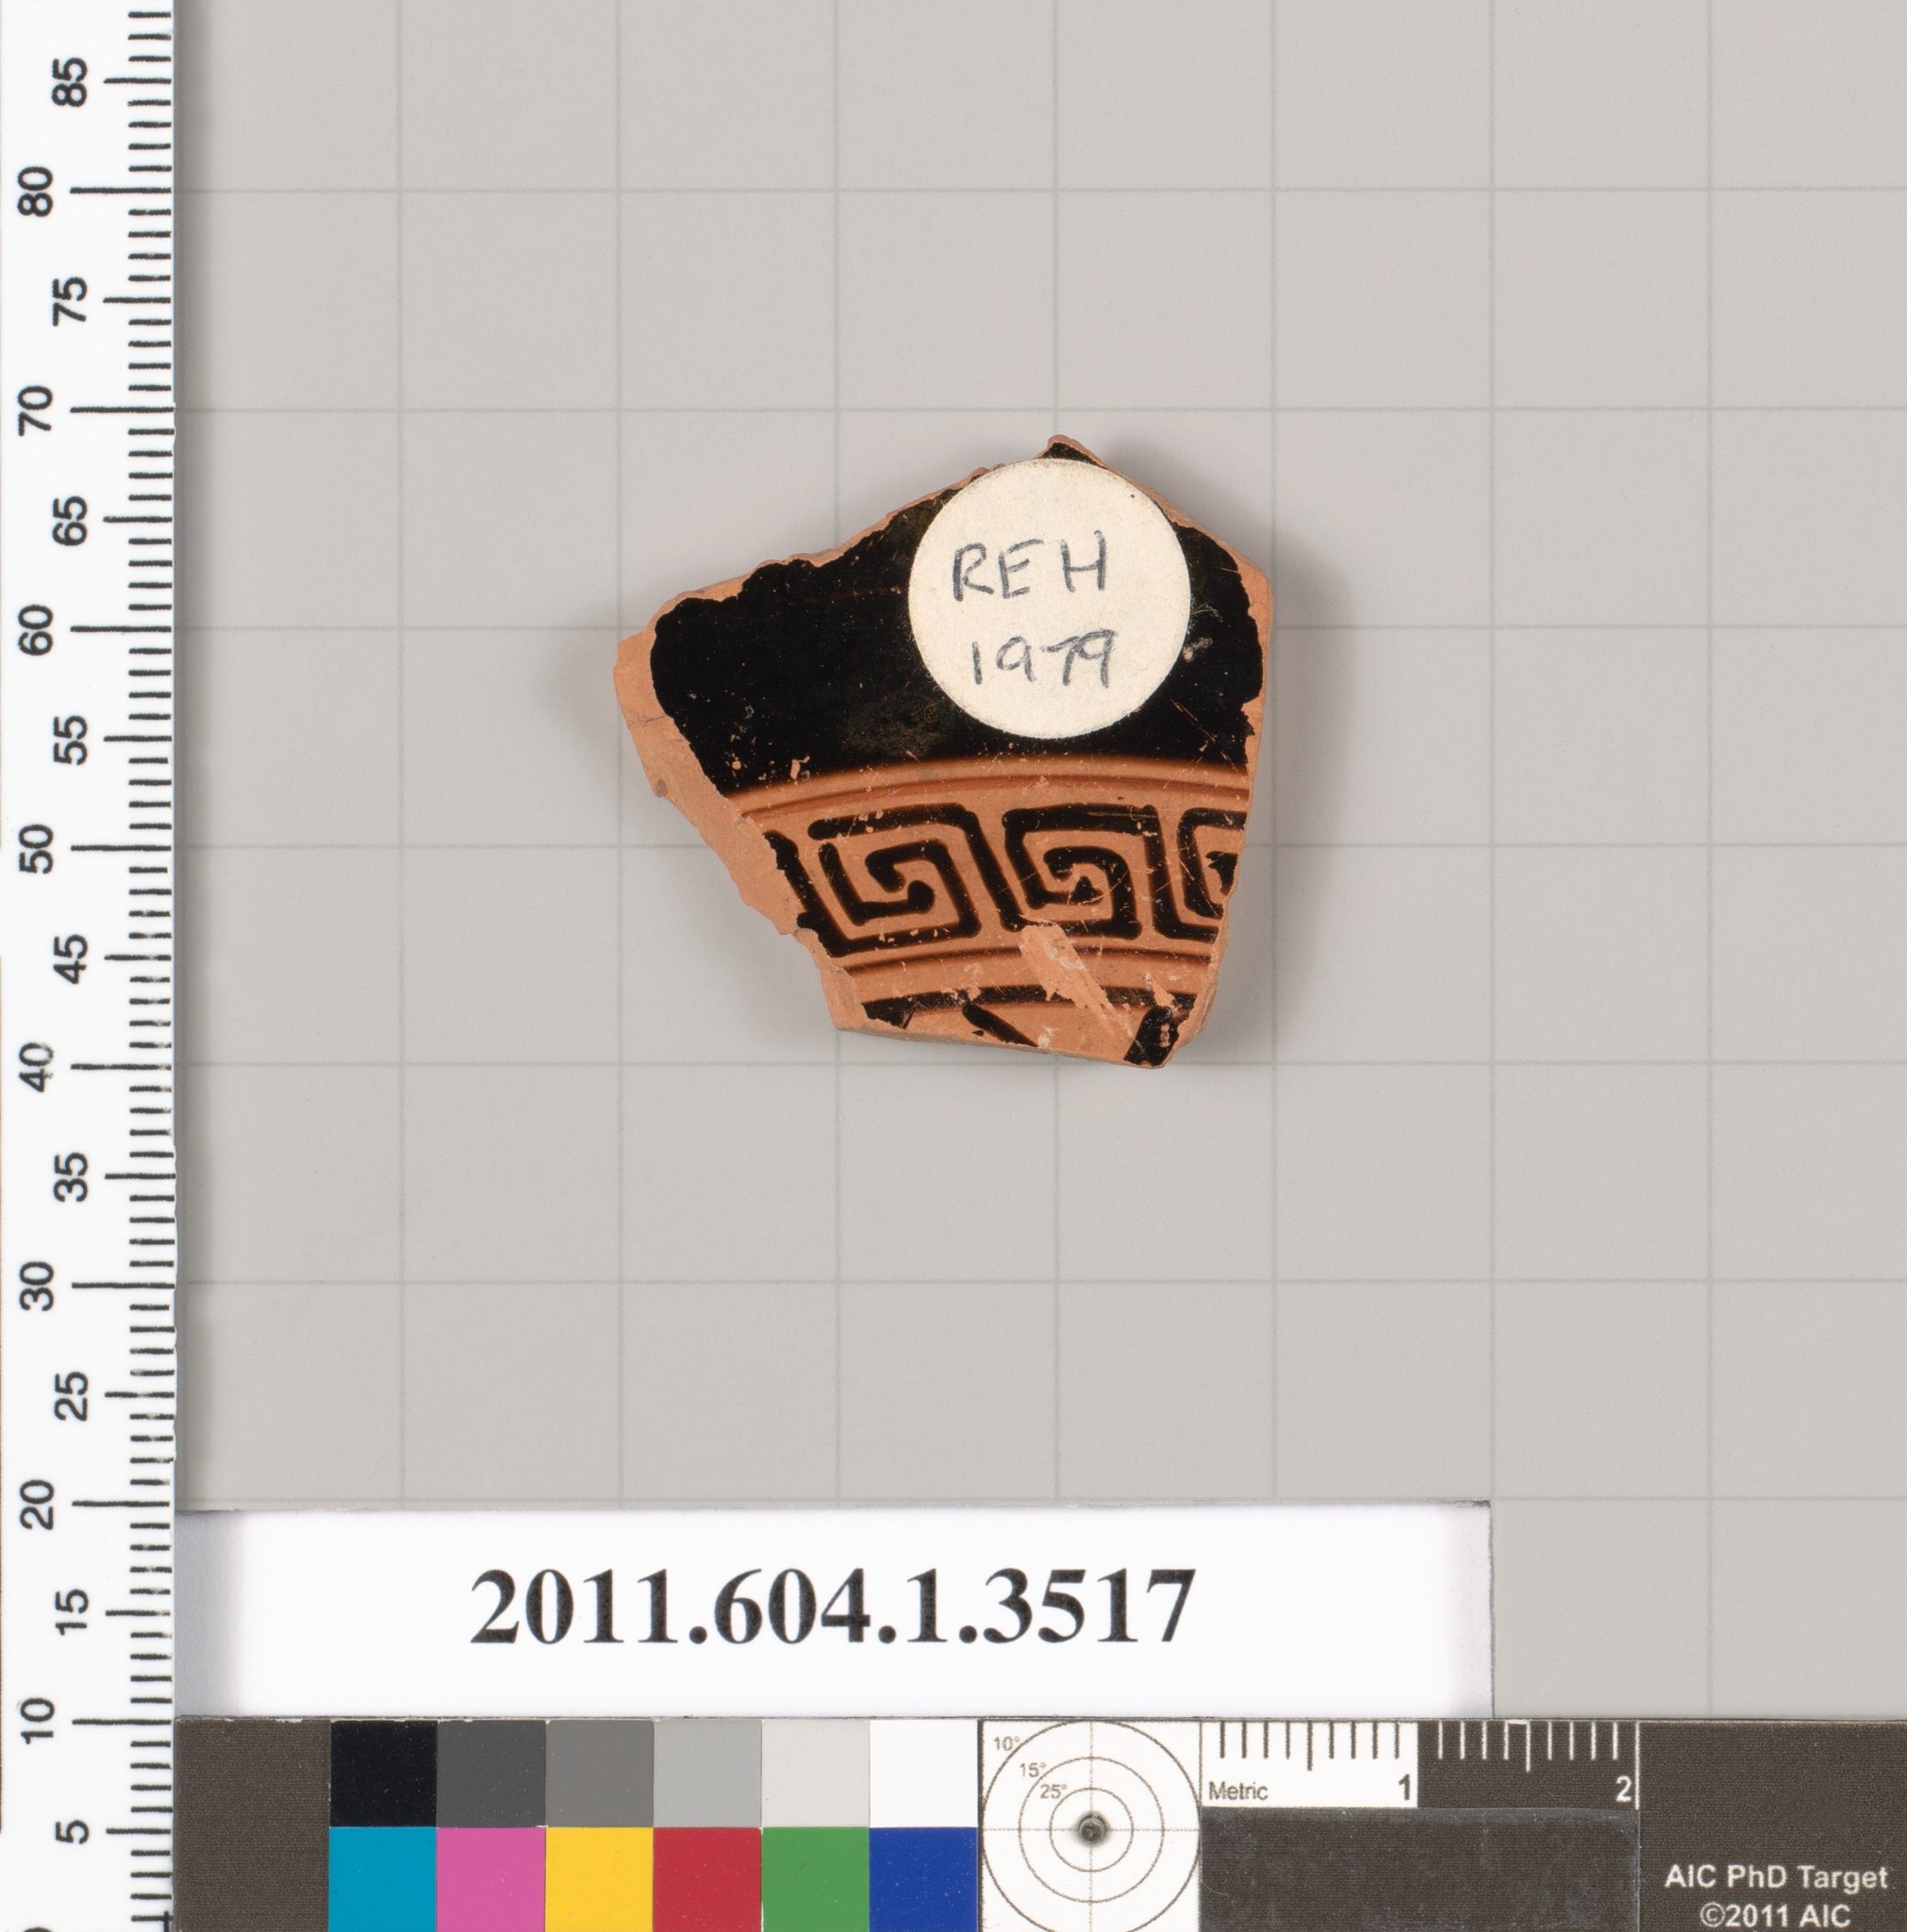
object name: kylix fragment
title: Terracotta fragment of a kylix (drinking cup)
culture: greek, attic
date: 470-450 BCE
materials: terracotta